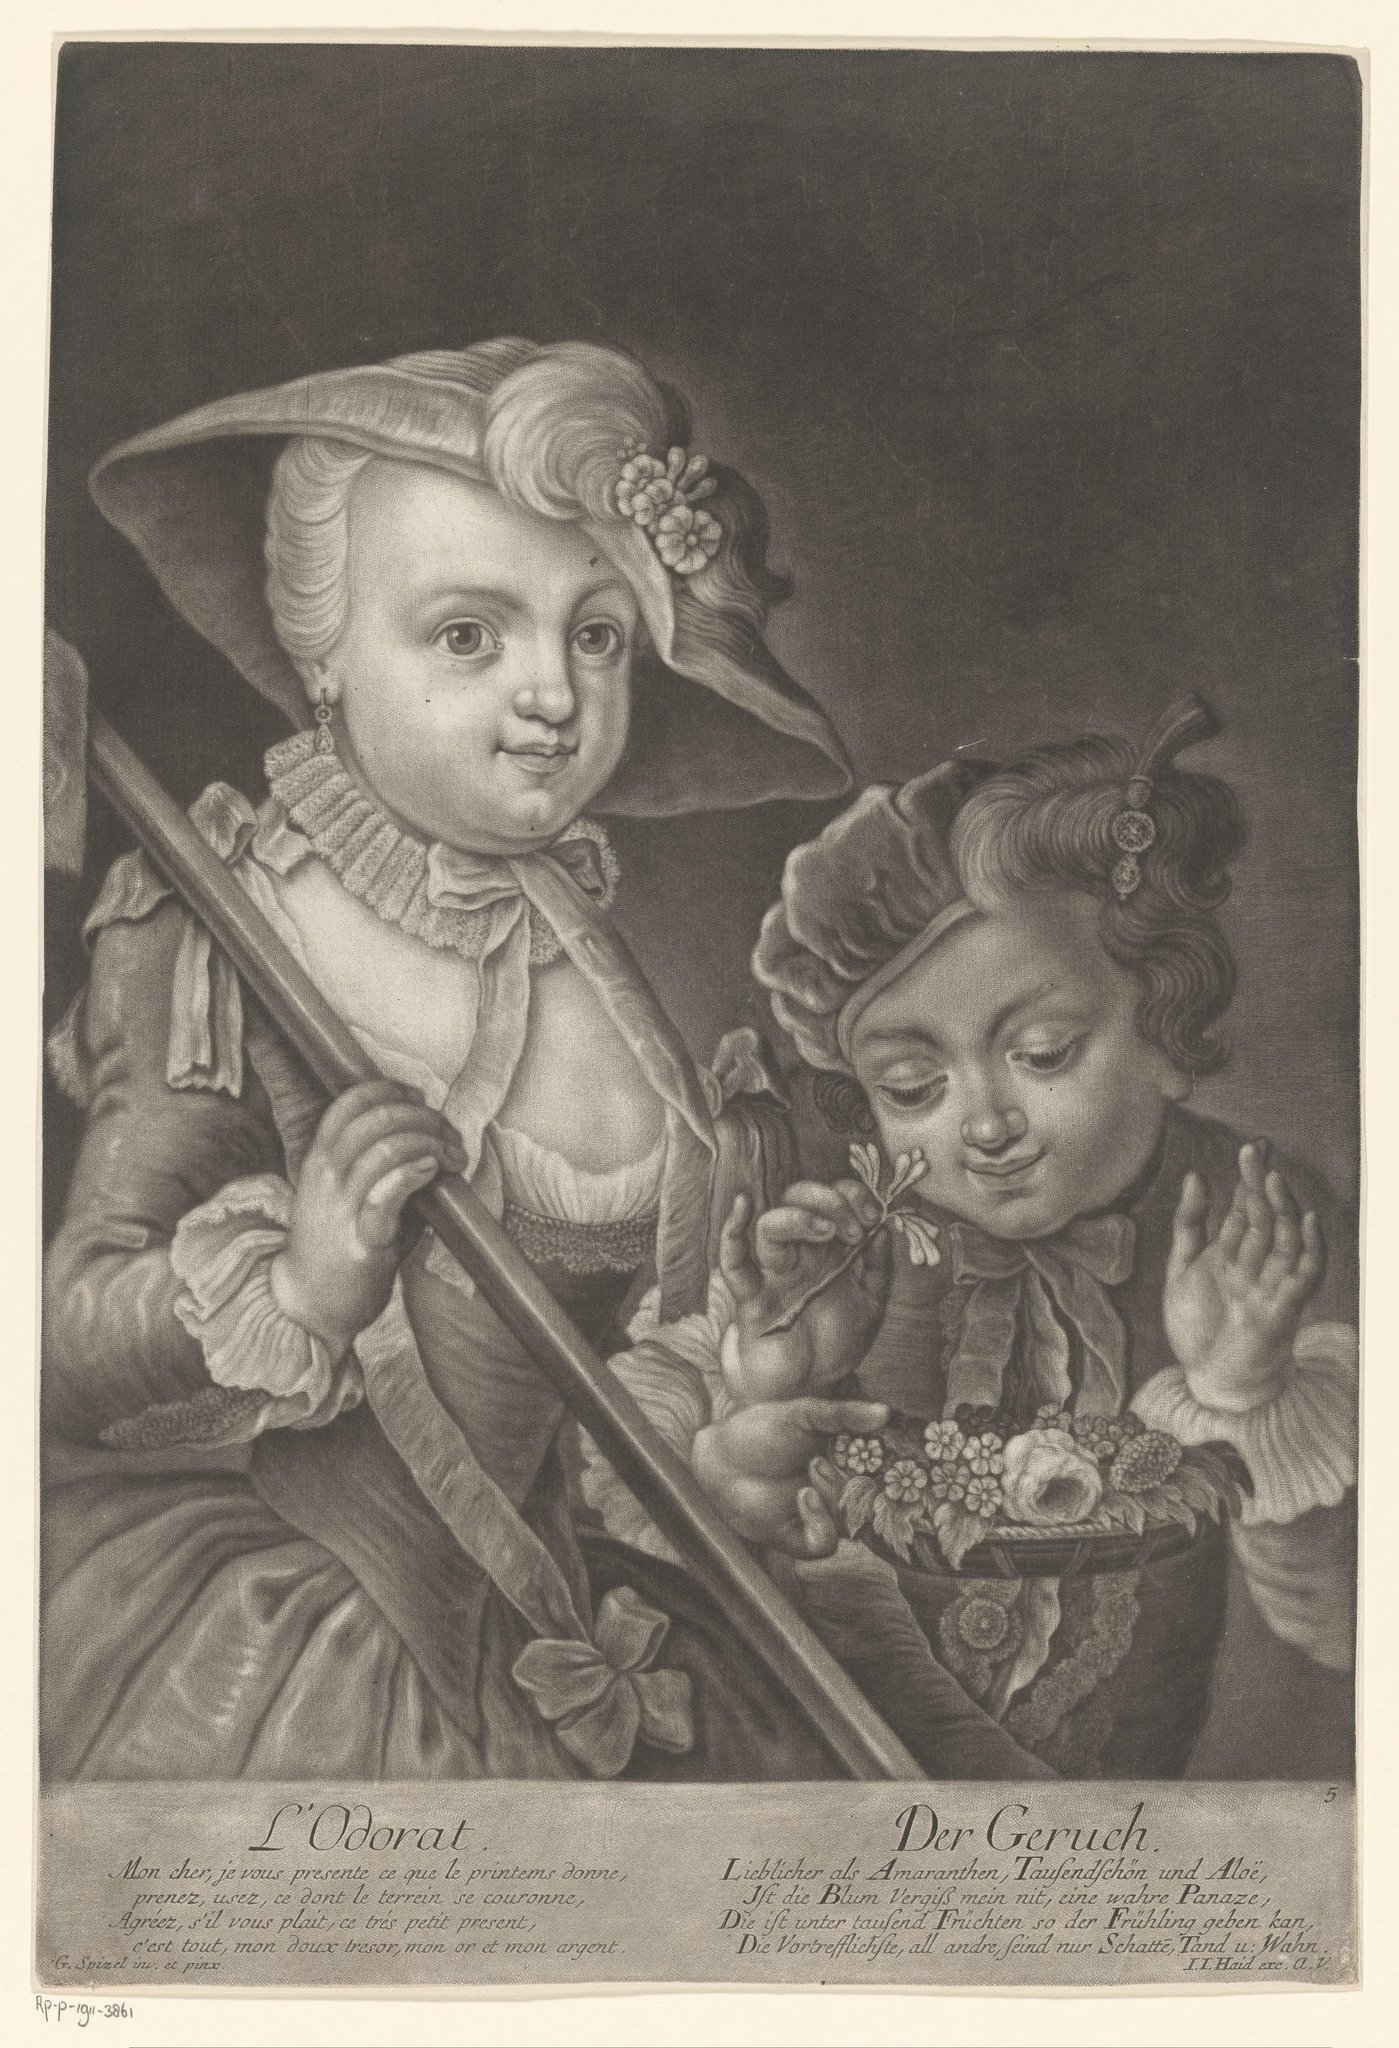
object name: print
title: Reuk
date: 1714-1767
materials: paper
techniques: mezzotint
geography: augsburg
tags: cut flowers; nosegay, bunch of flowers, smell, smelling (one of the five senses)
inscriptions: collector's mark: Lugt 2228